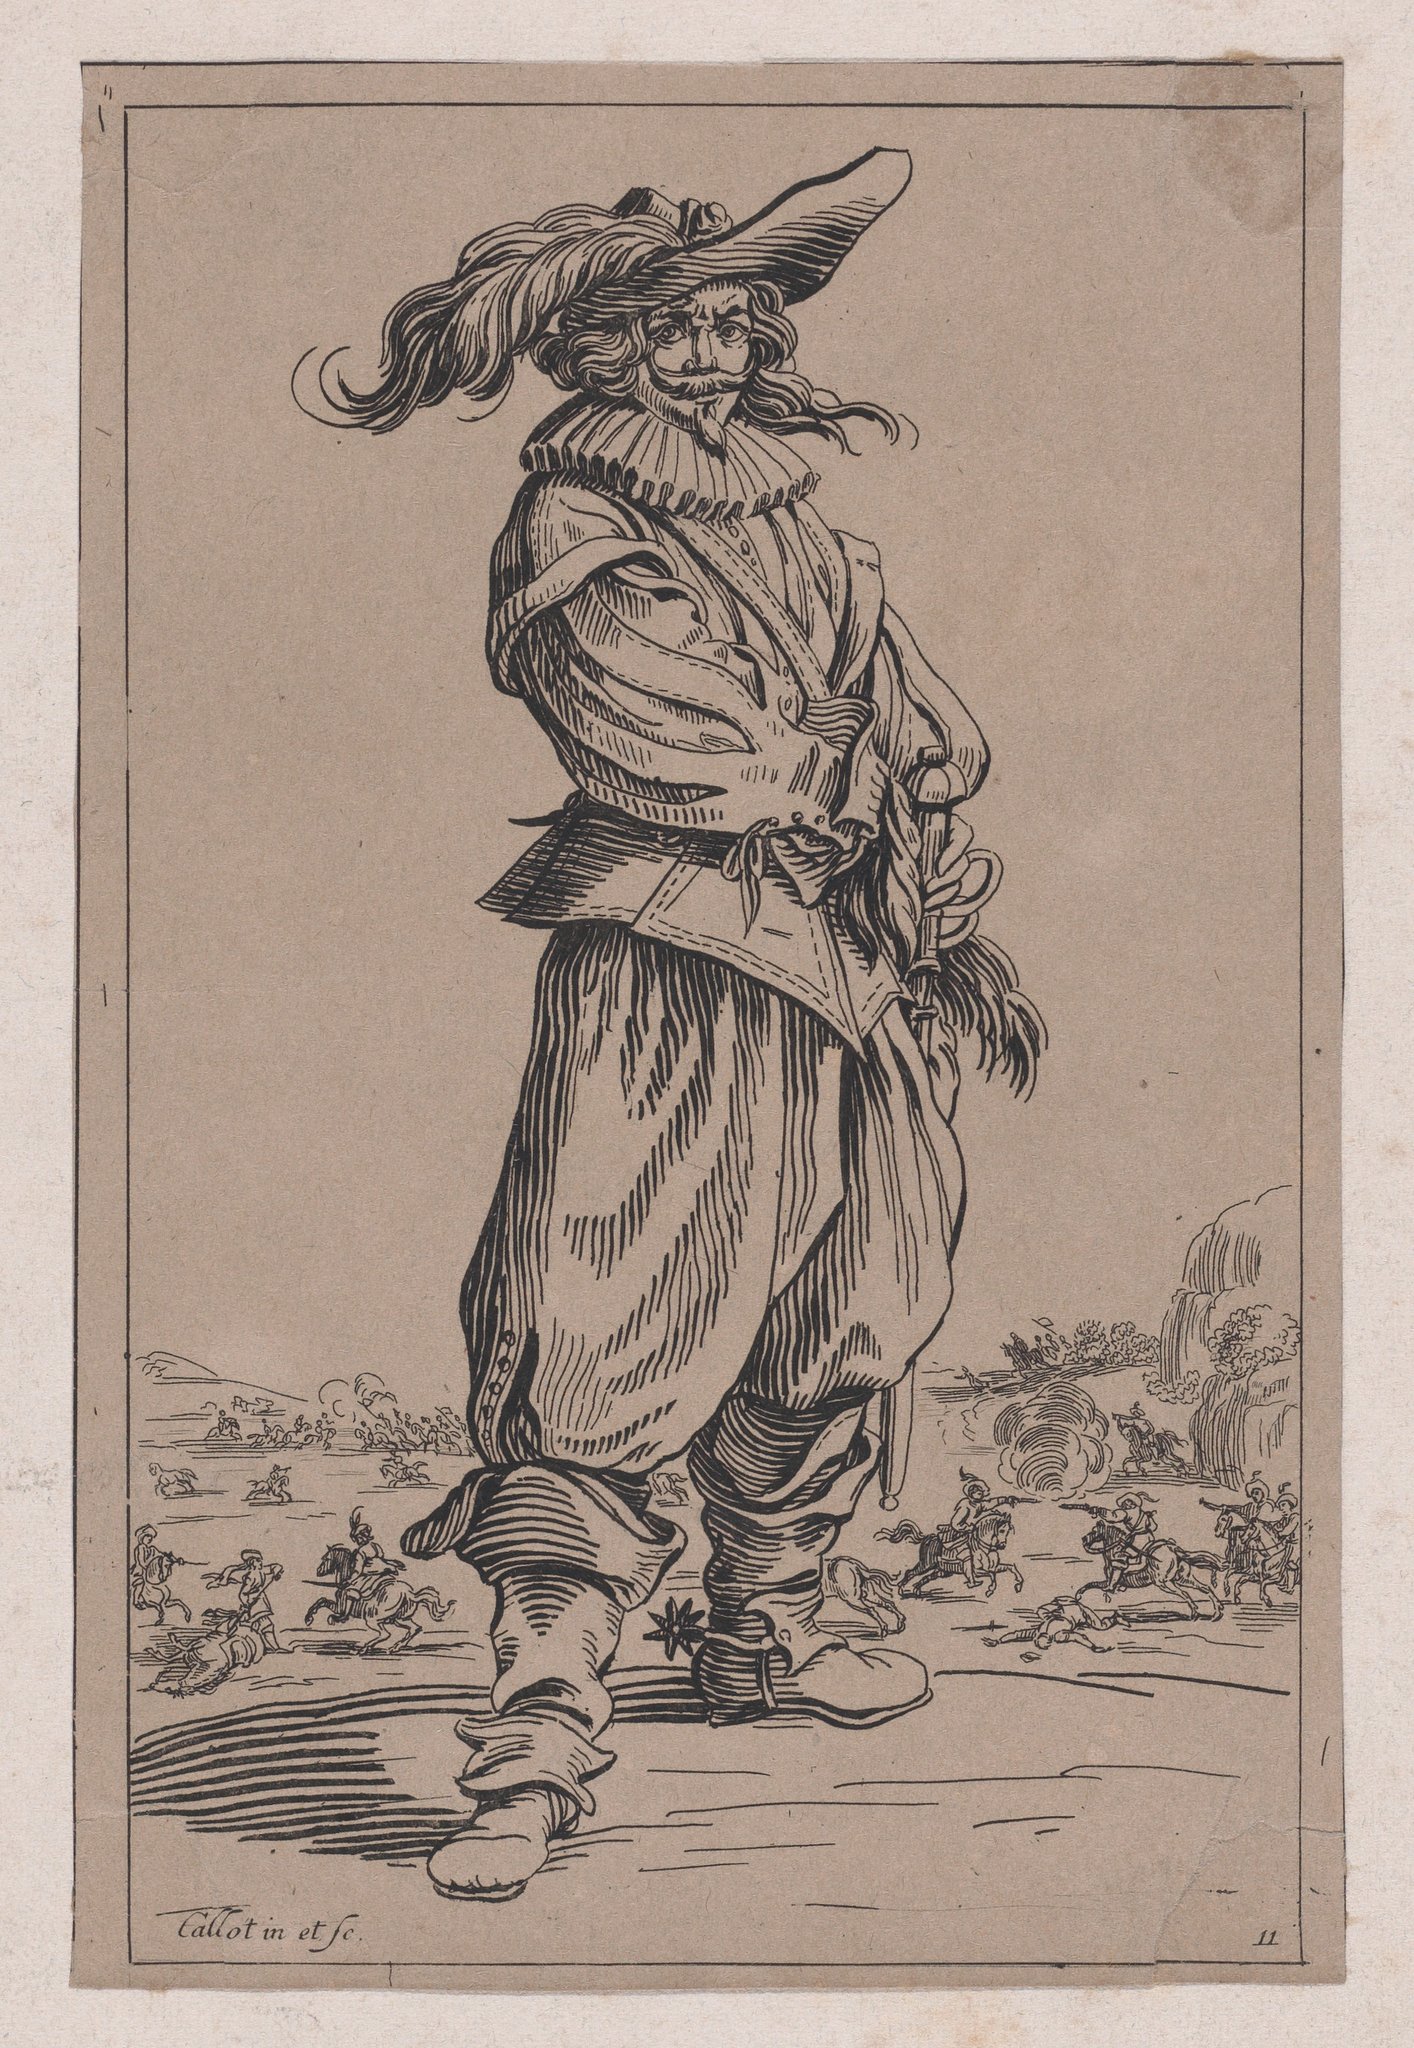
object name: print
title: Copy of Le Guerrier au Chapeau Orné d'une Grande Plume (The Officer with a Large Feather in His Hat), from "La Noblesse" (The Nobility)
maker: Anonymous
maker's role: artist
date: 1601-1700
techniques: etching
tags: men